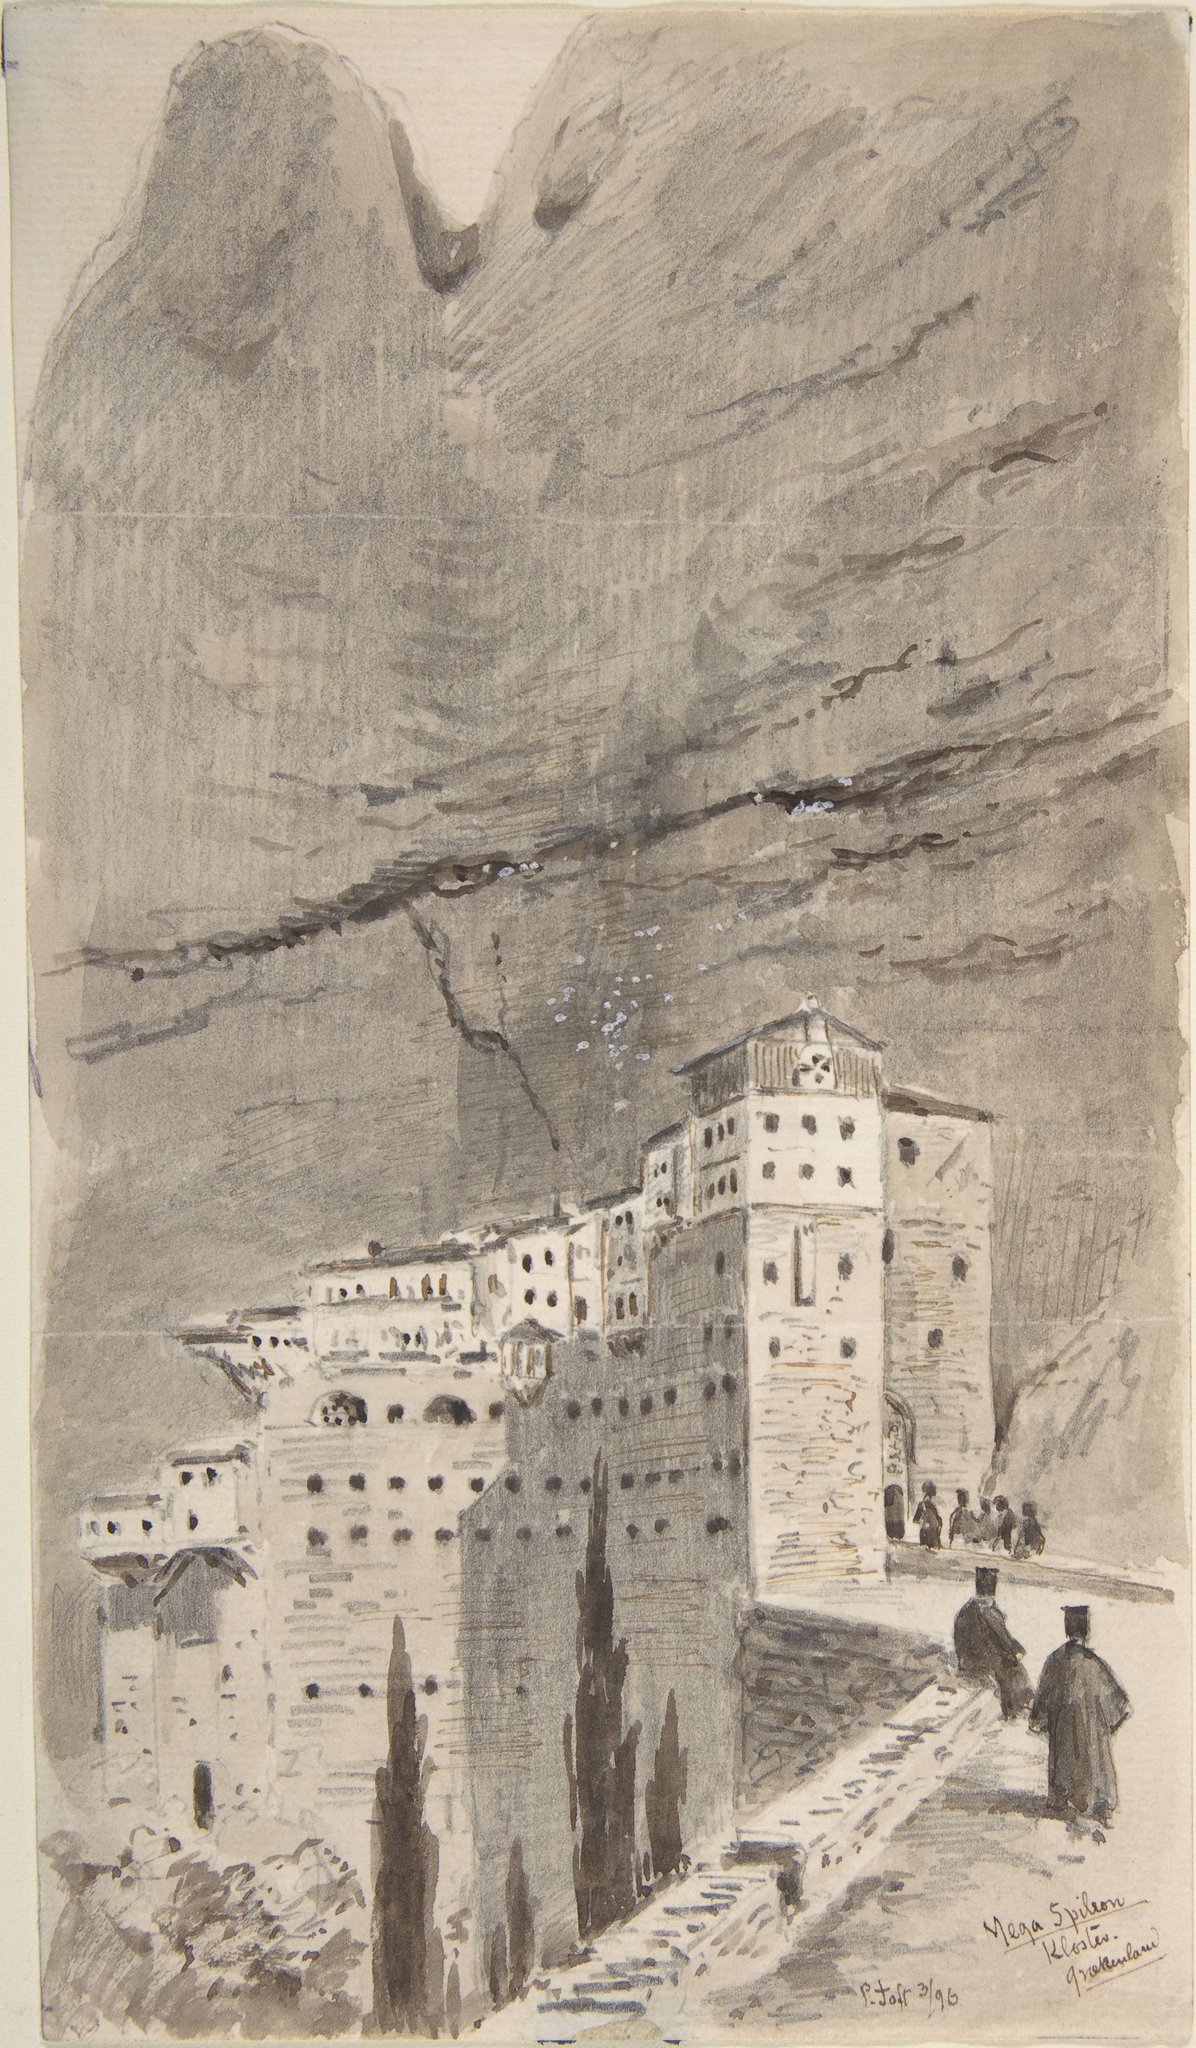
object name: drawing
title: Monastery of Mega Spileon, Greece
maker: peter toft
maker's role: artist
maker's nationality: danish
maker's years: 1825-1901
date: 1896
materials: gouache, graphite, ink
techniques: brush, heightening, pen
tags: human figures,buildings